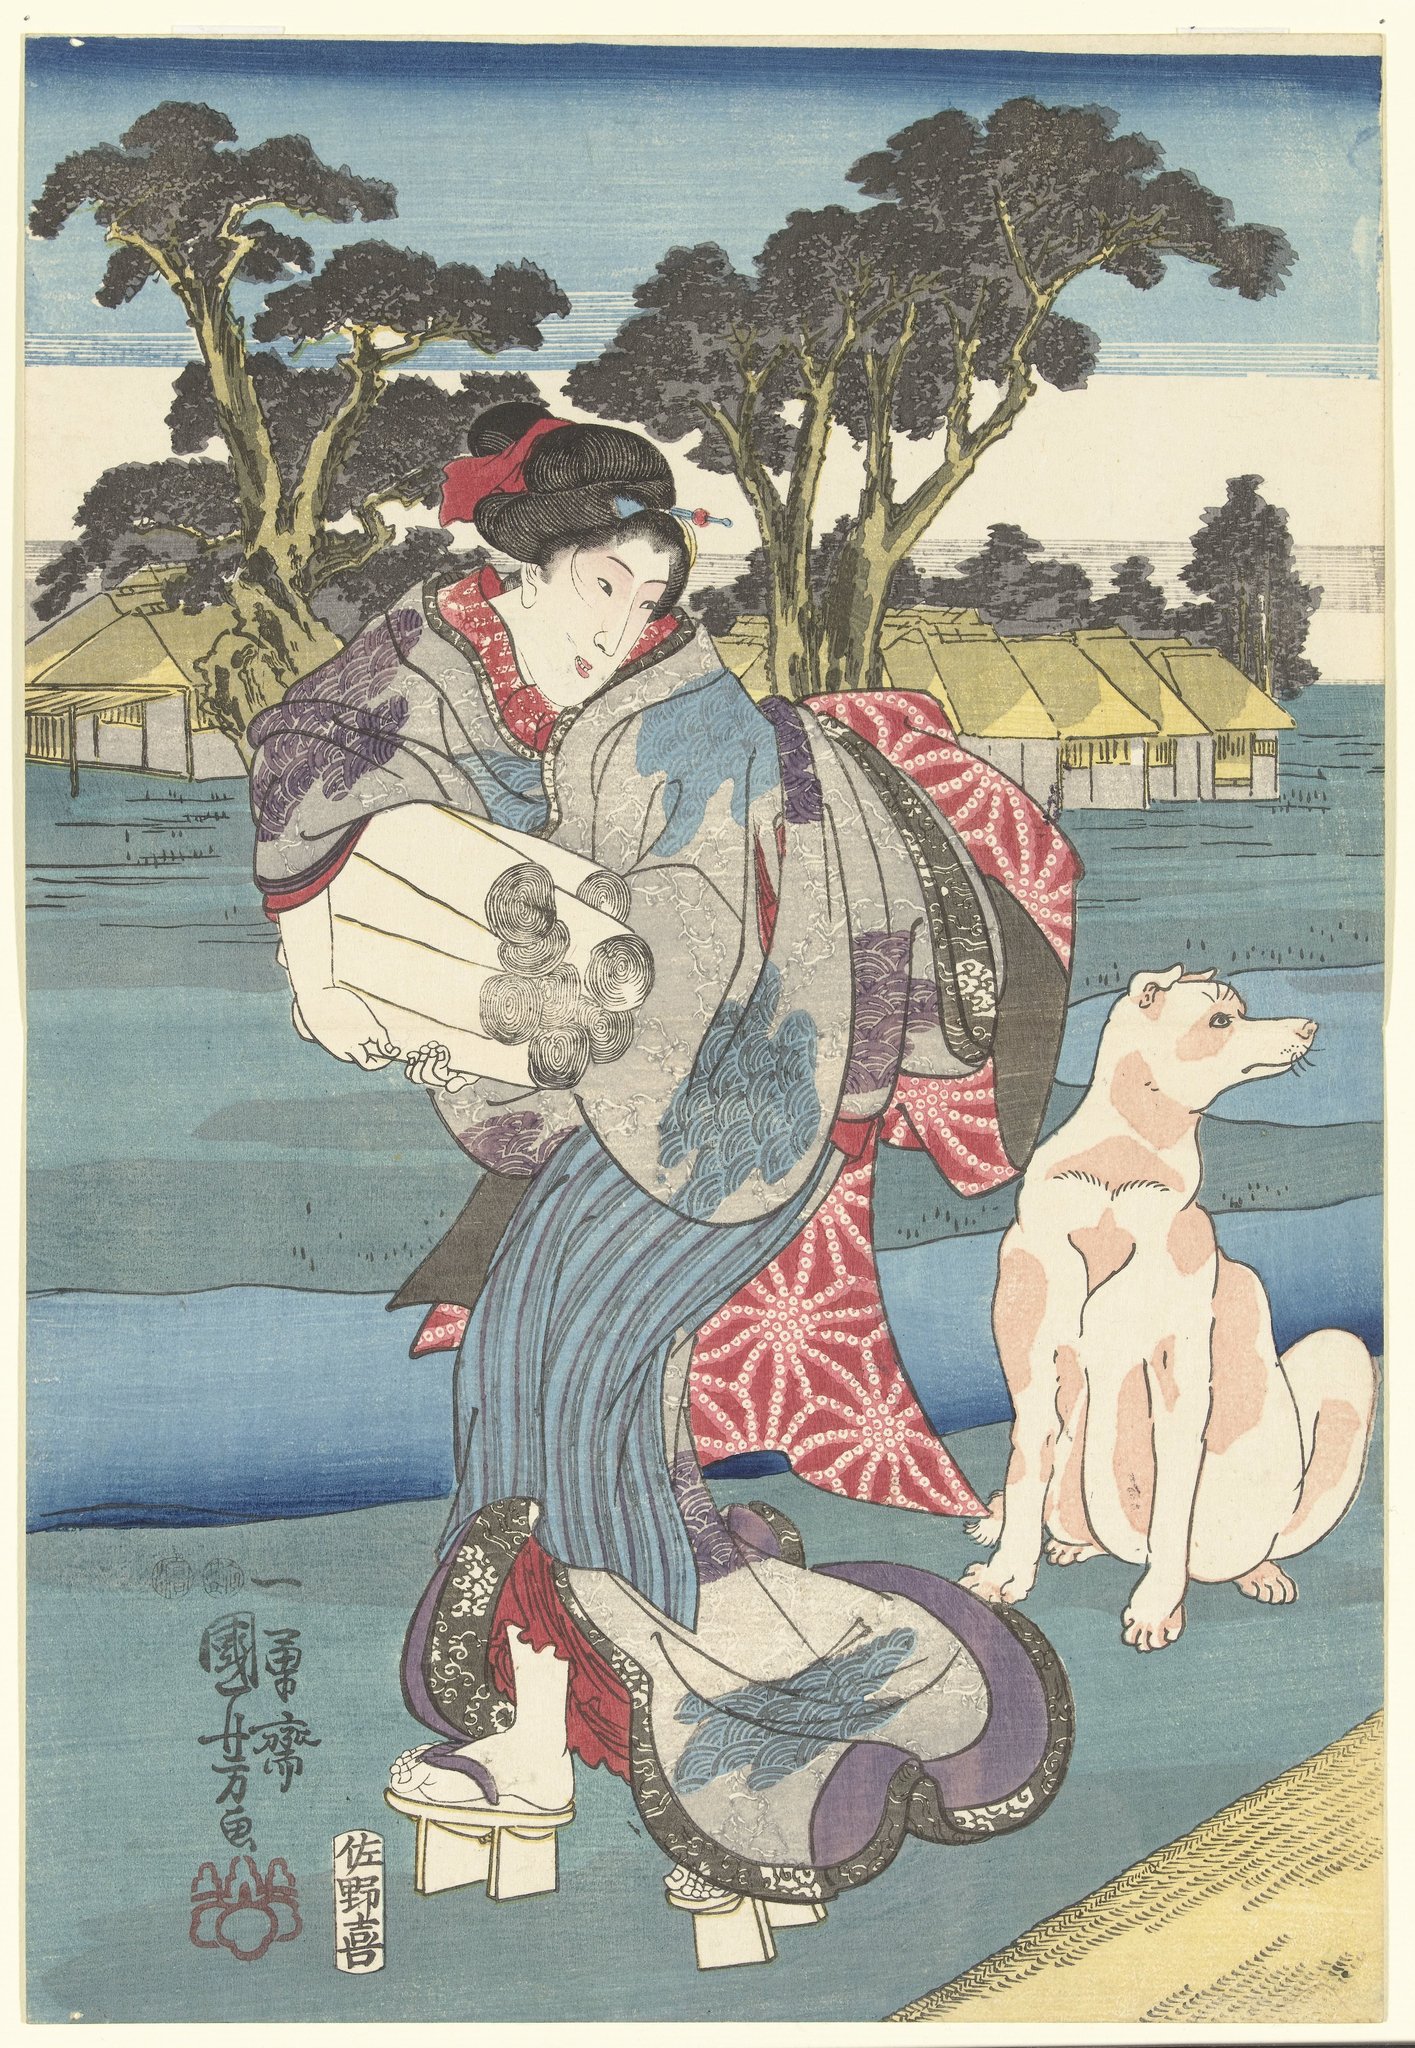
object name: print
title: De Toi Tama rivier in de provincie Settsu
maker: utagawa kuniyoshi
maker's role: draughtsman, print maker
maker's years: 1798-1861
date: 1847-1848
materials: paper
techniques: woodcut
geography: tokyo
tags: fulling ~ cloth finishing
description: Vrouw met rollen wit laken onder haar armen, staand naast hond; rivier en dorpje tussen bomen op de achtergrond.